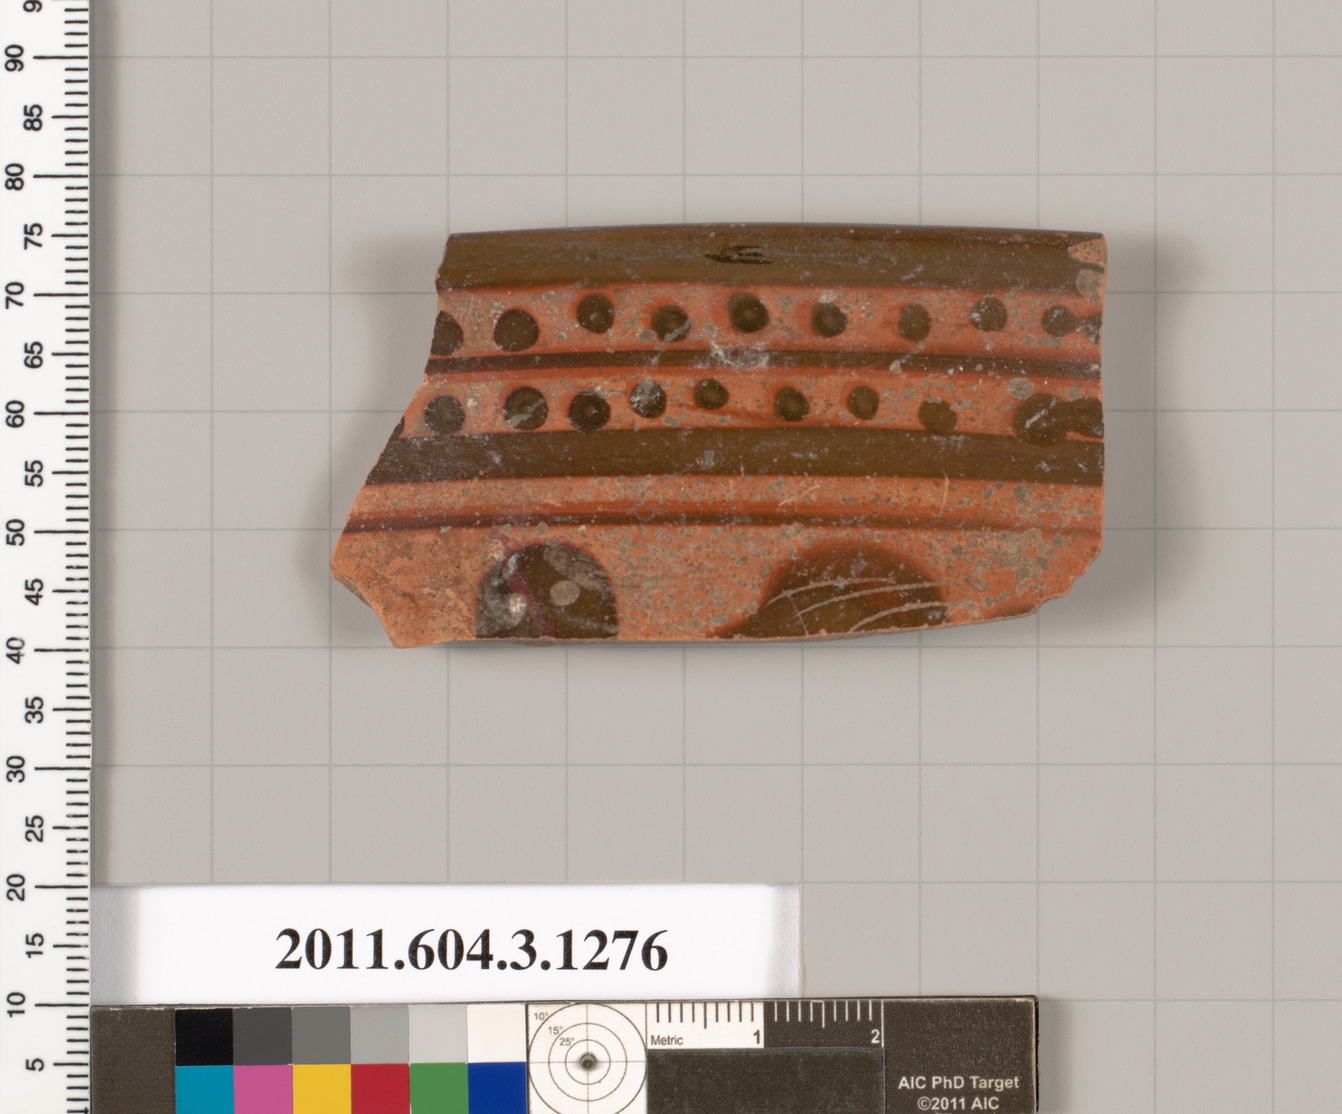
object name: skyphos fragment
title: Terracotta rim fragment of a skyphos (deep drinking cup)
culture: greek, attic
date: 500 BCE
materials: terracotta